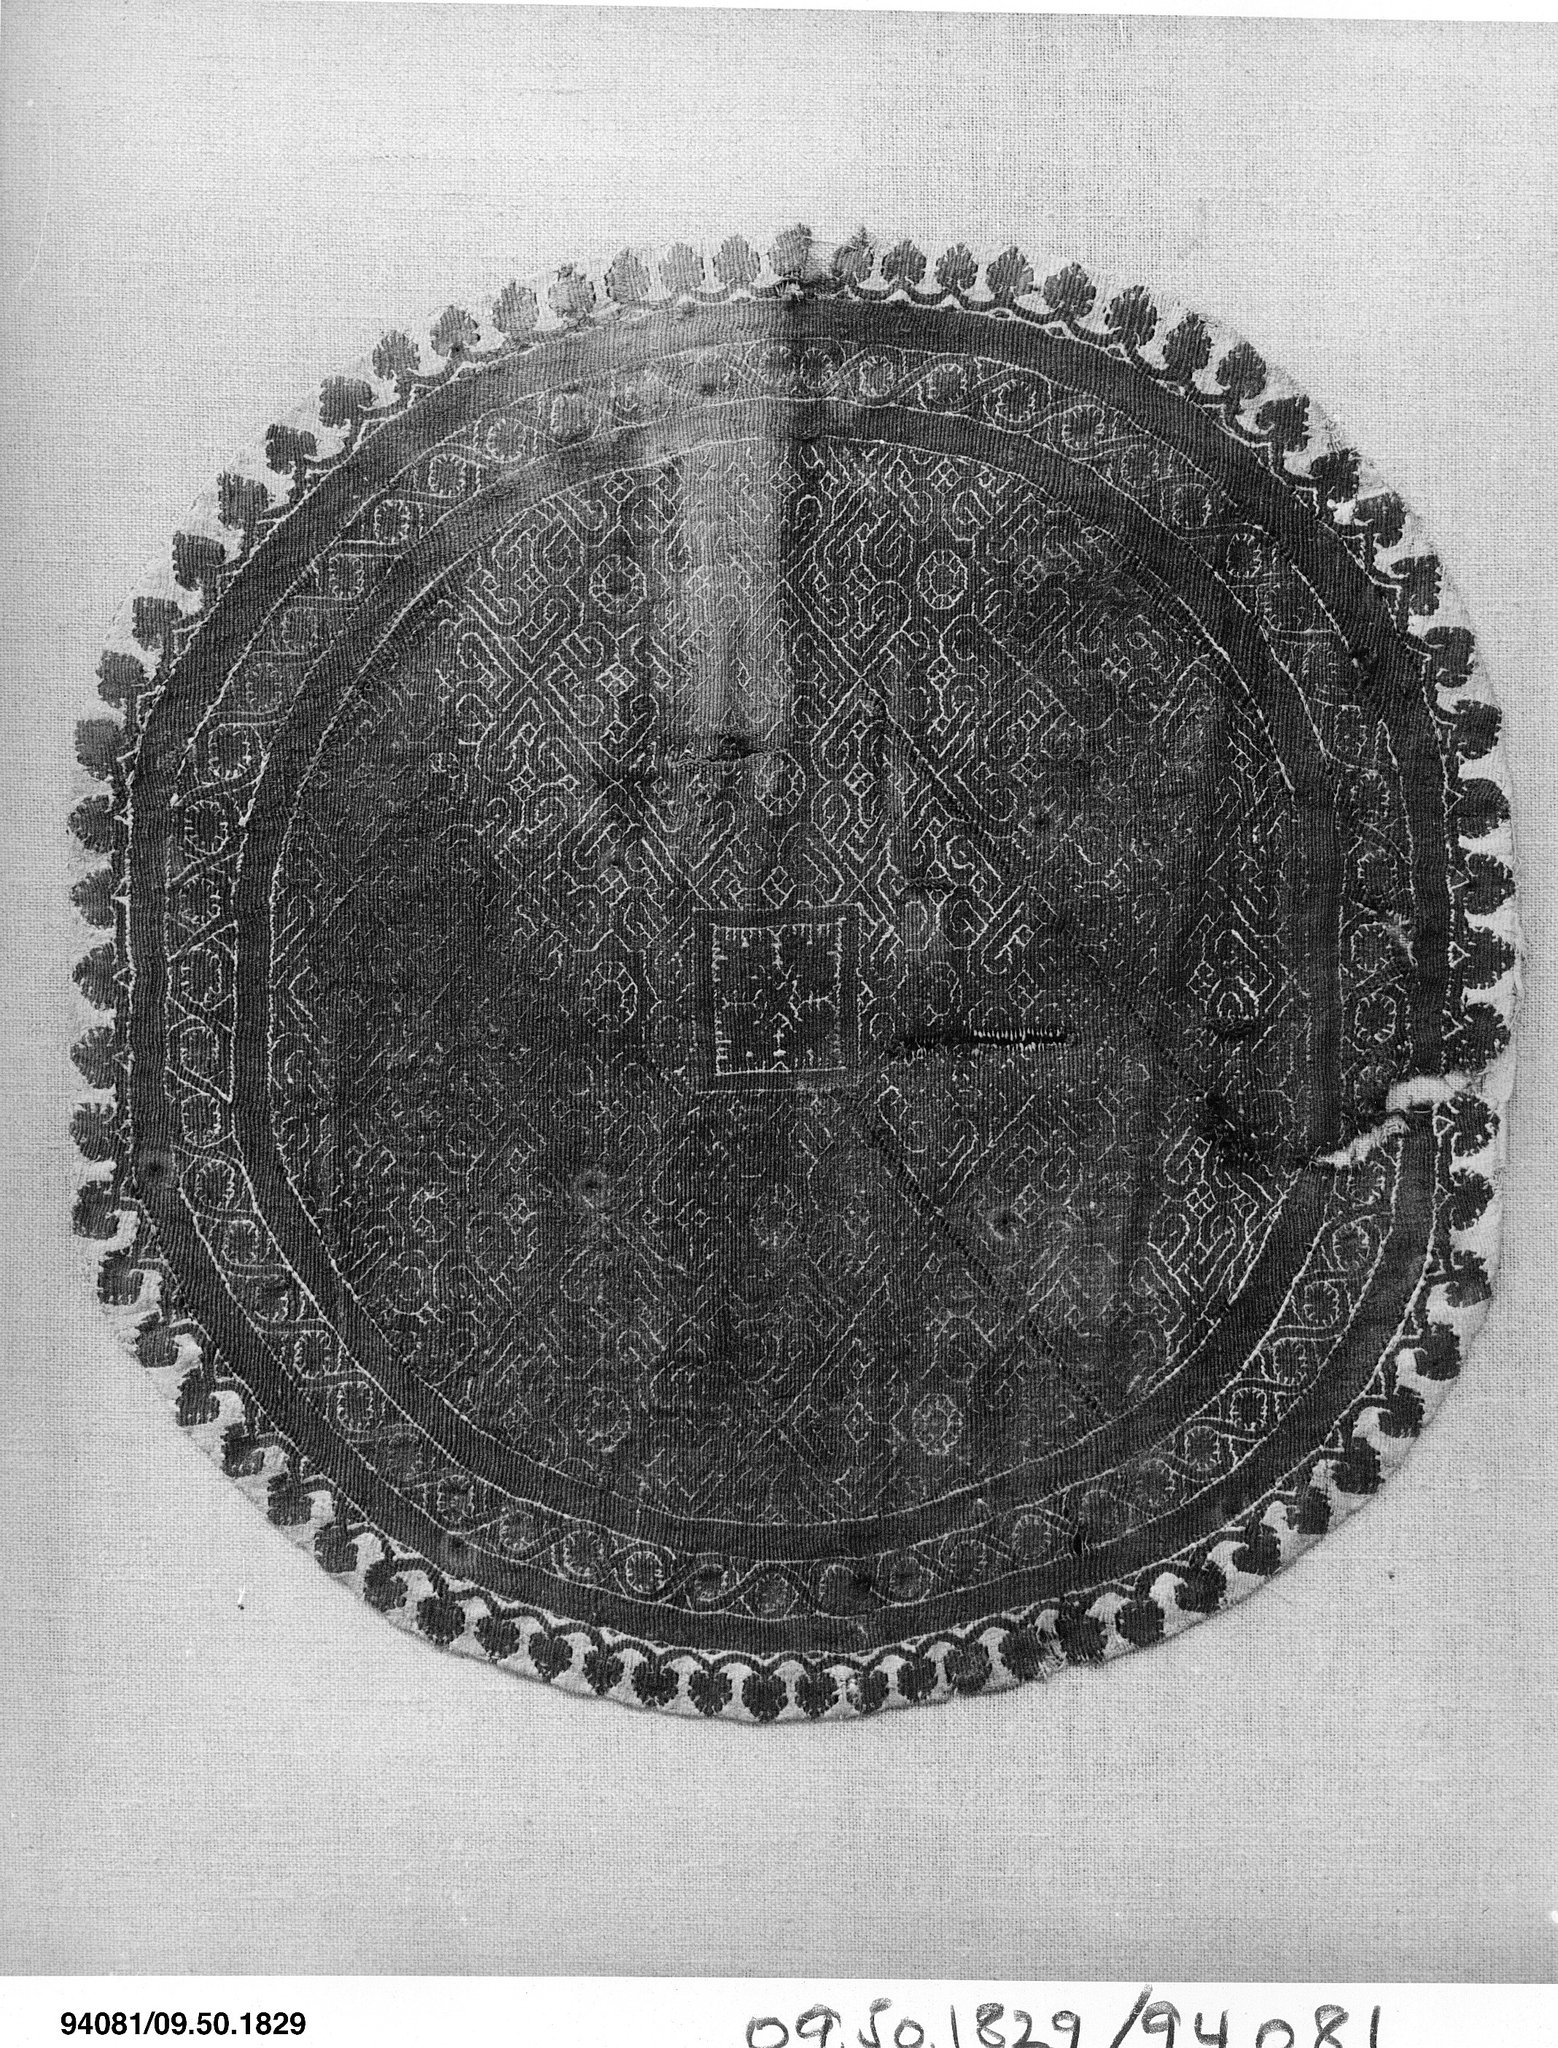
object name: roundel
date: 201-400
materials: linen, wool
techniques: weave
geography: egypt